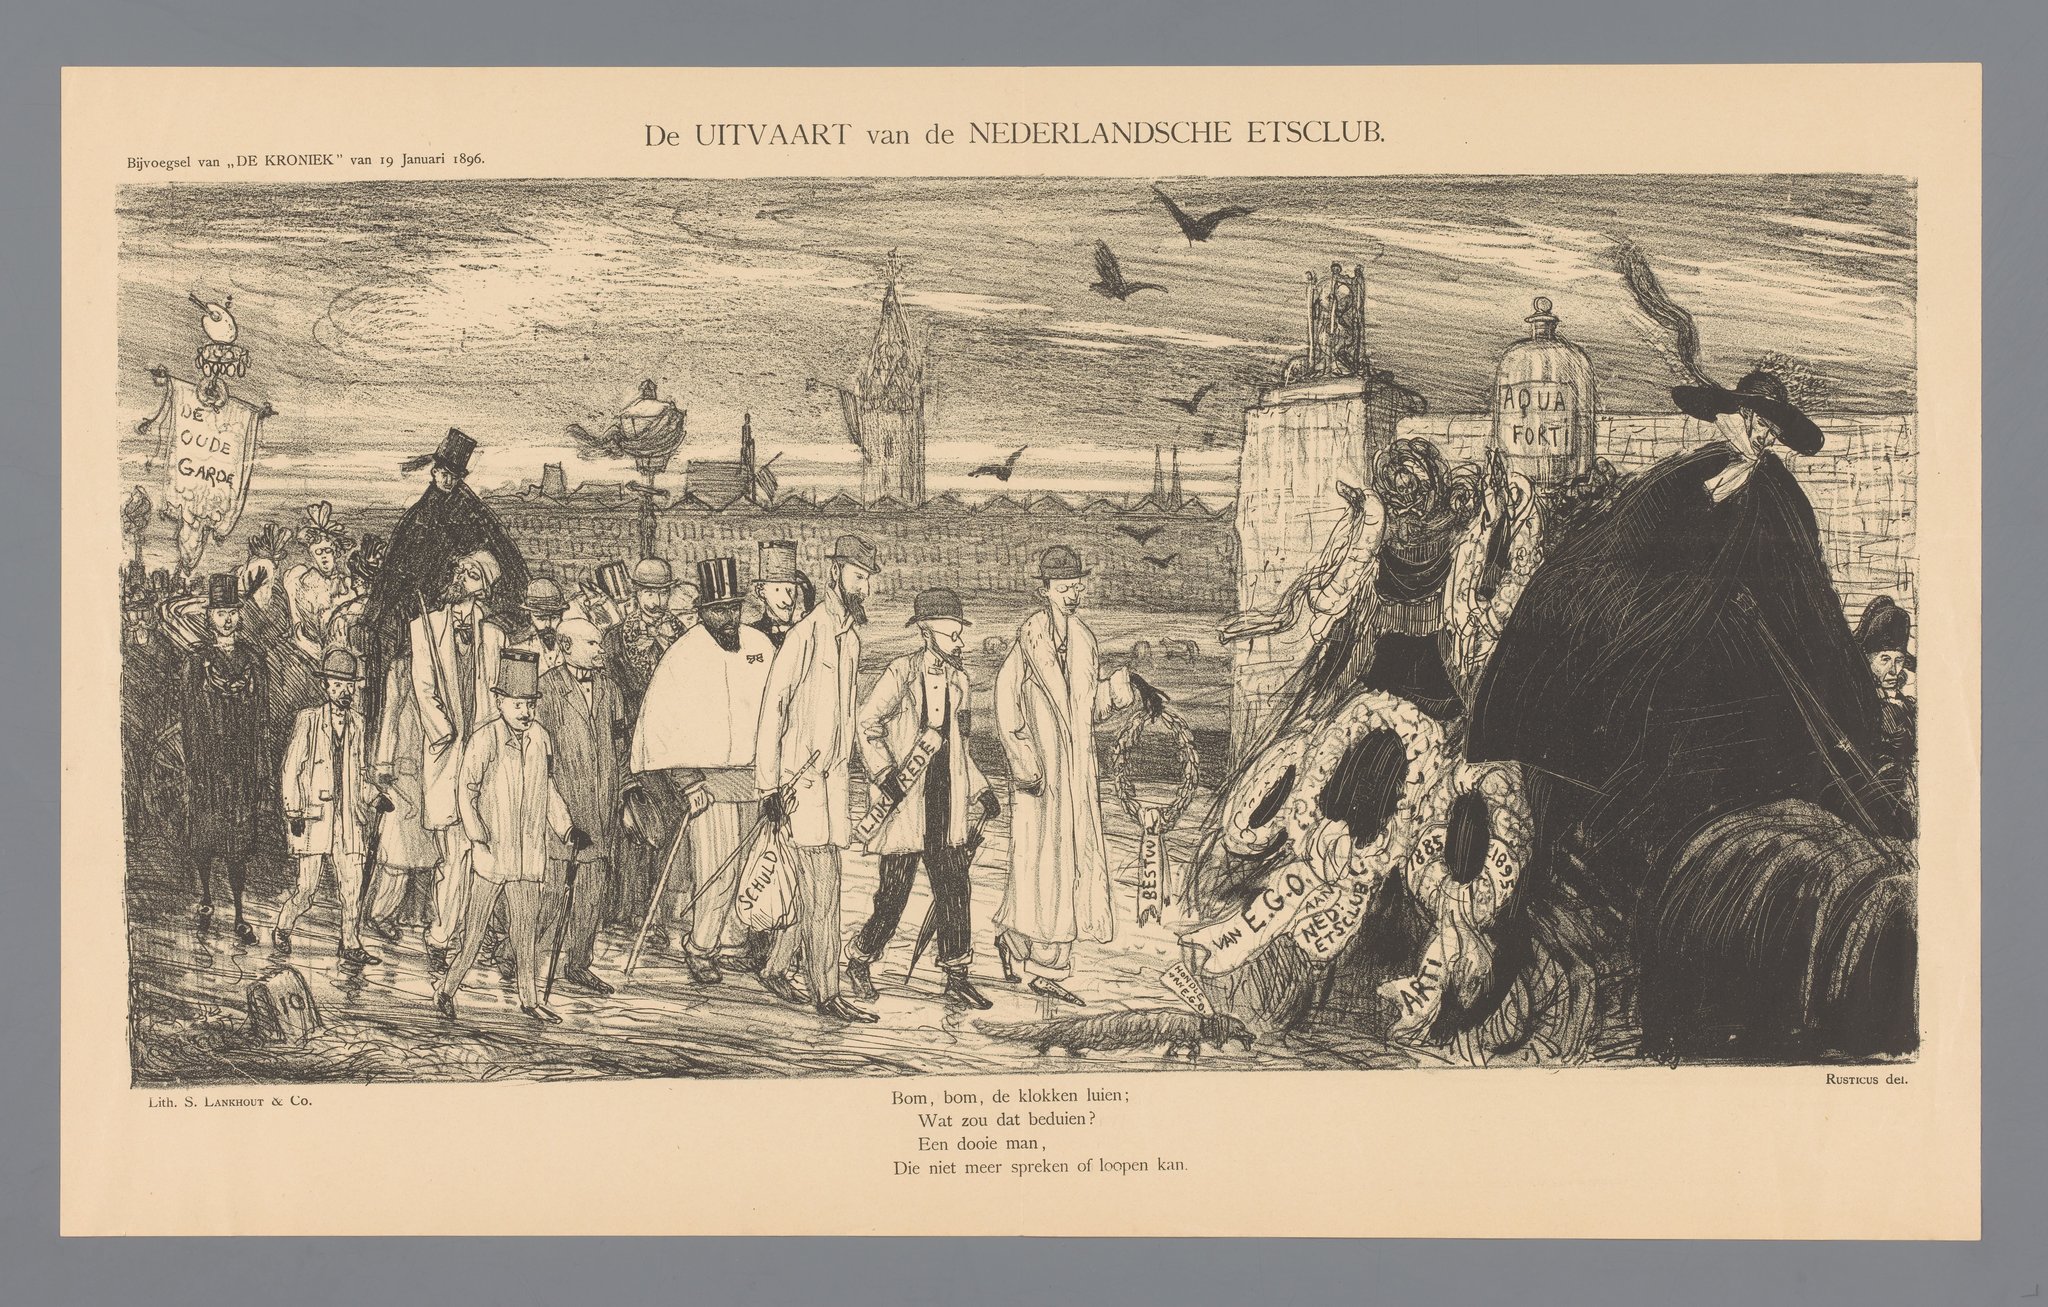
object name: cartoon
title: De uitvaart van de Nederlandsche etsclub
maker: marius bauer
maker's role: draughtsman, print maker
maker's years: 1867-1932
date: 1896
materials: paper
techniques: lithograph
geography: the hague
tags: thérèse schwartze, dordrecht, designer, jan veth, marinus van der maarel, maurits van der valk, etienne bosch, haarlem, painter, anton l. koster, marius bauer, wally moes, amsterdam, the hague, draughtsman, hendrik johannes haverman, utrecht, print maker, etha fles, jan toorop, philip zilcken, cortege, funeral procession, graphic artist, political caricatures and satires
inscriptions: date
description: Spotprent waarin de Nederlandsche Etsclub ten grave wordt gedragen. De Etsclub hief zichzelf op op 13 januari 1896. Vooraan in de stoet de lijkwagen met rouwkransen 1885-1895, daarachter lopen de leden: Jan Veth (met bord 'lijkrede'), Philip Zilcken, Maurits van der Valk, Marinus van der Maarel, Etienne Bosch, Anton L. Koster, Hendrik J. Haverman en Jan Toorp. Marius Bauer heeft zichzelf als penningmeester van de Etsclub afgebeeld met de zak met het opschrift 'schuld'. Achter deze groep volgen de damesleden in een rijtuig: Etha Fles, Wally Moes en Thérèse Schwartze. Achteraan de stoet 'De Oude Garde'.